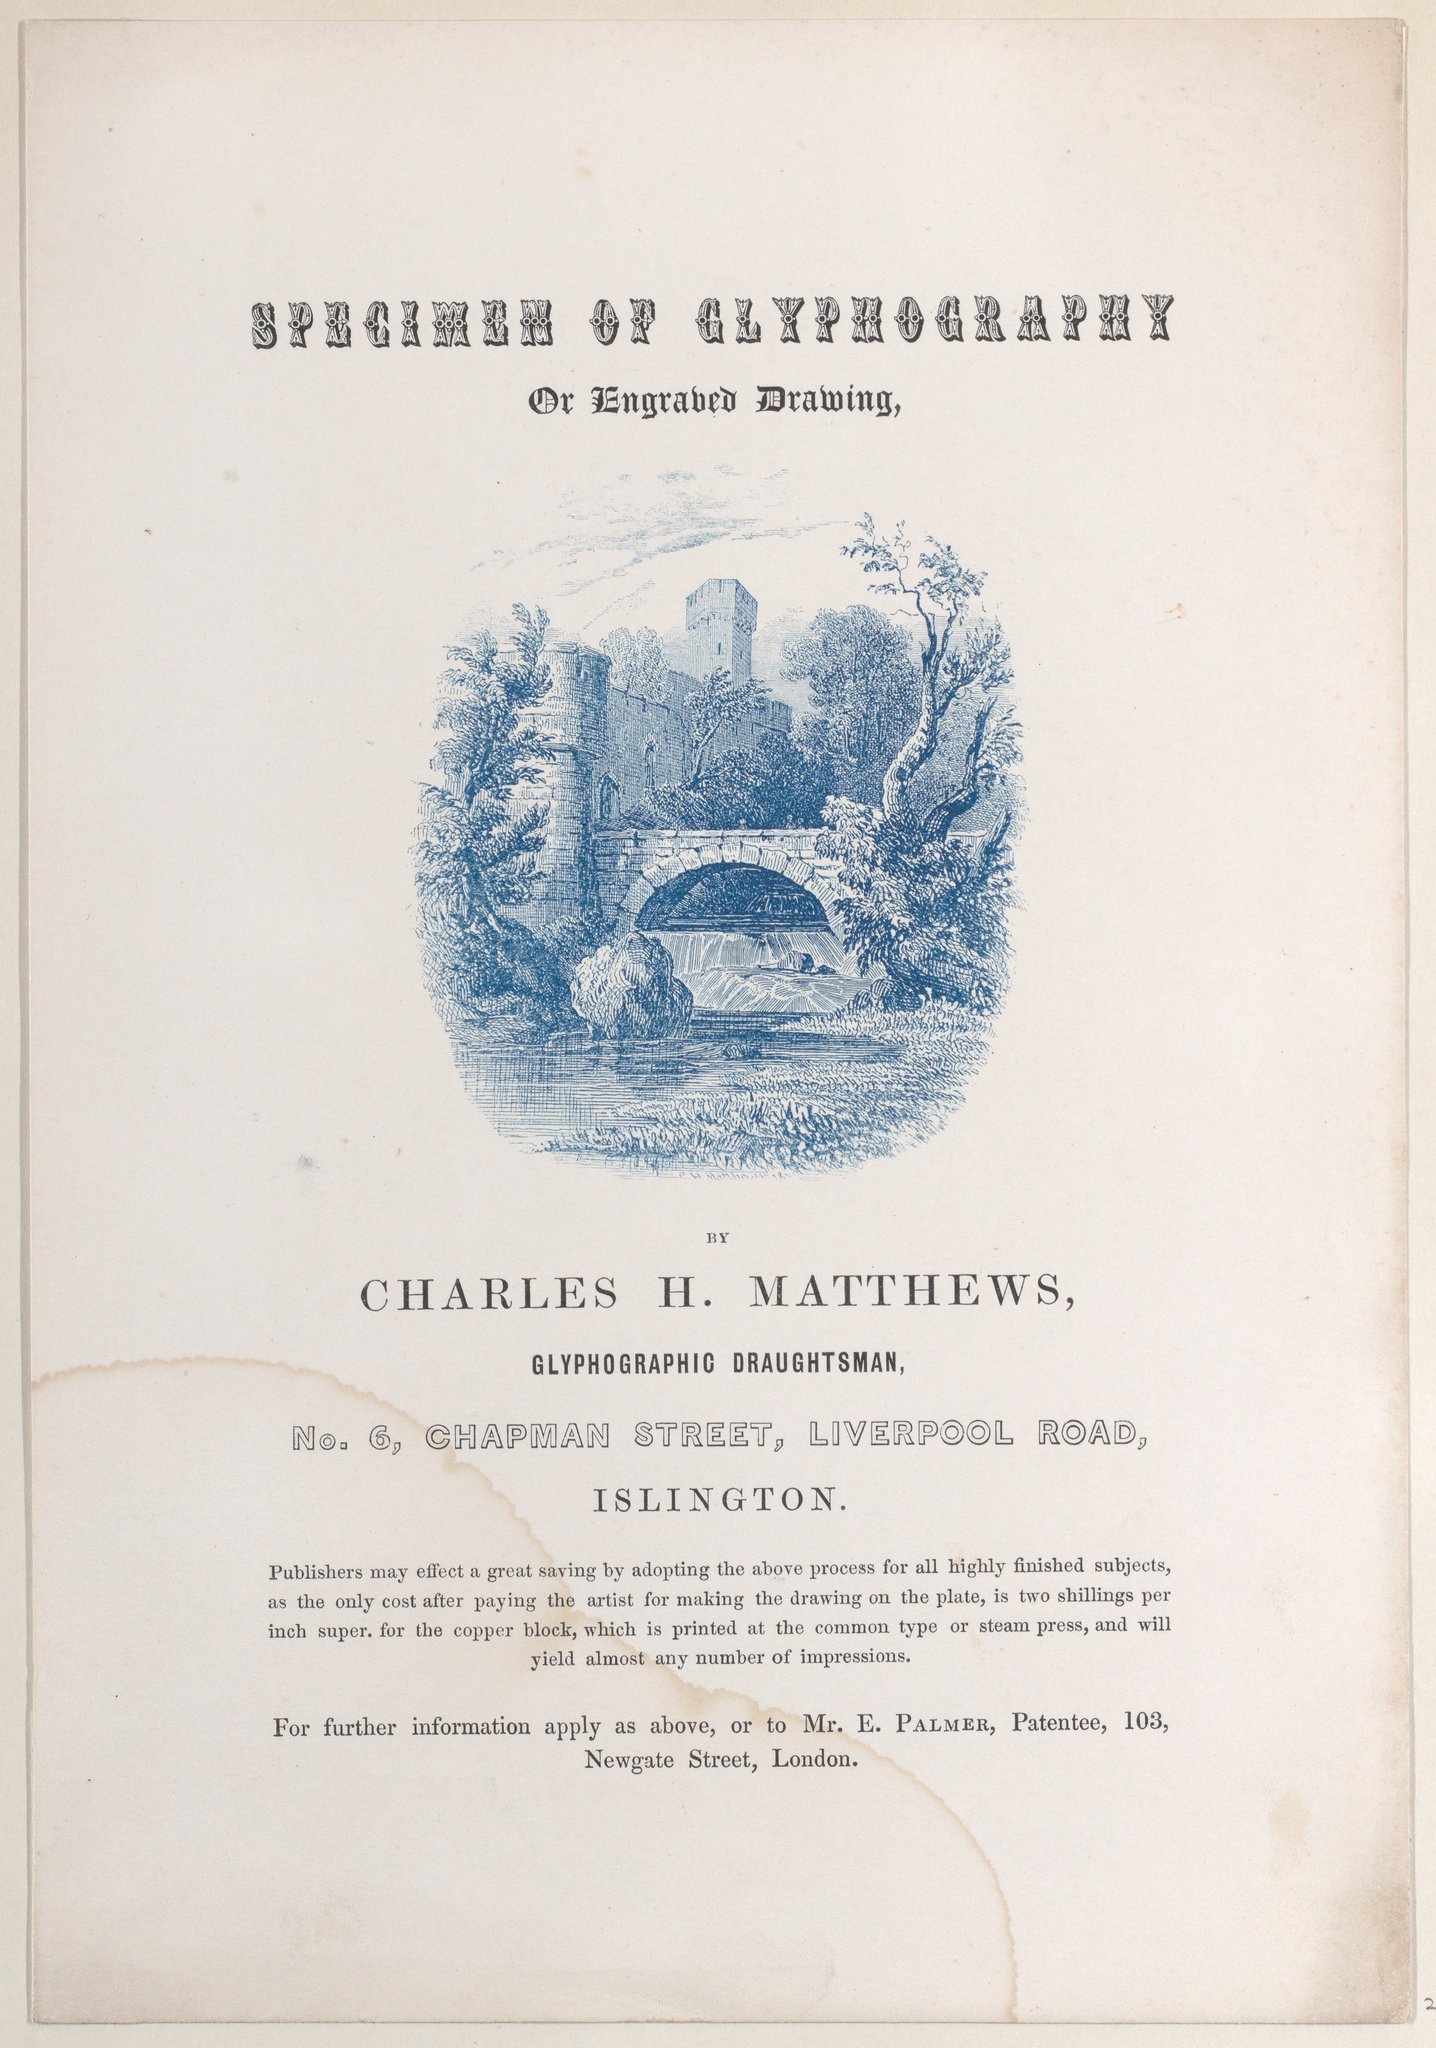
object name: print, trade card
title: Trade Card for Charles H. Matthews, glyphographic draughtsman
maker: anonymous, british, 19th century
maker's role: artist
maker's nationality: british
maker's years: 1800-1900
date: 1801-1900